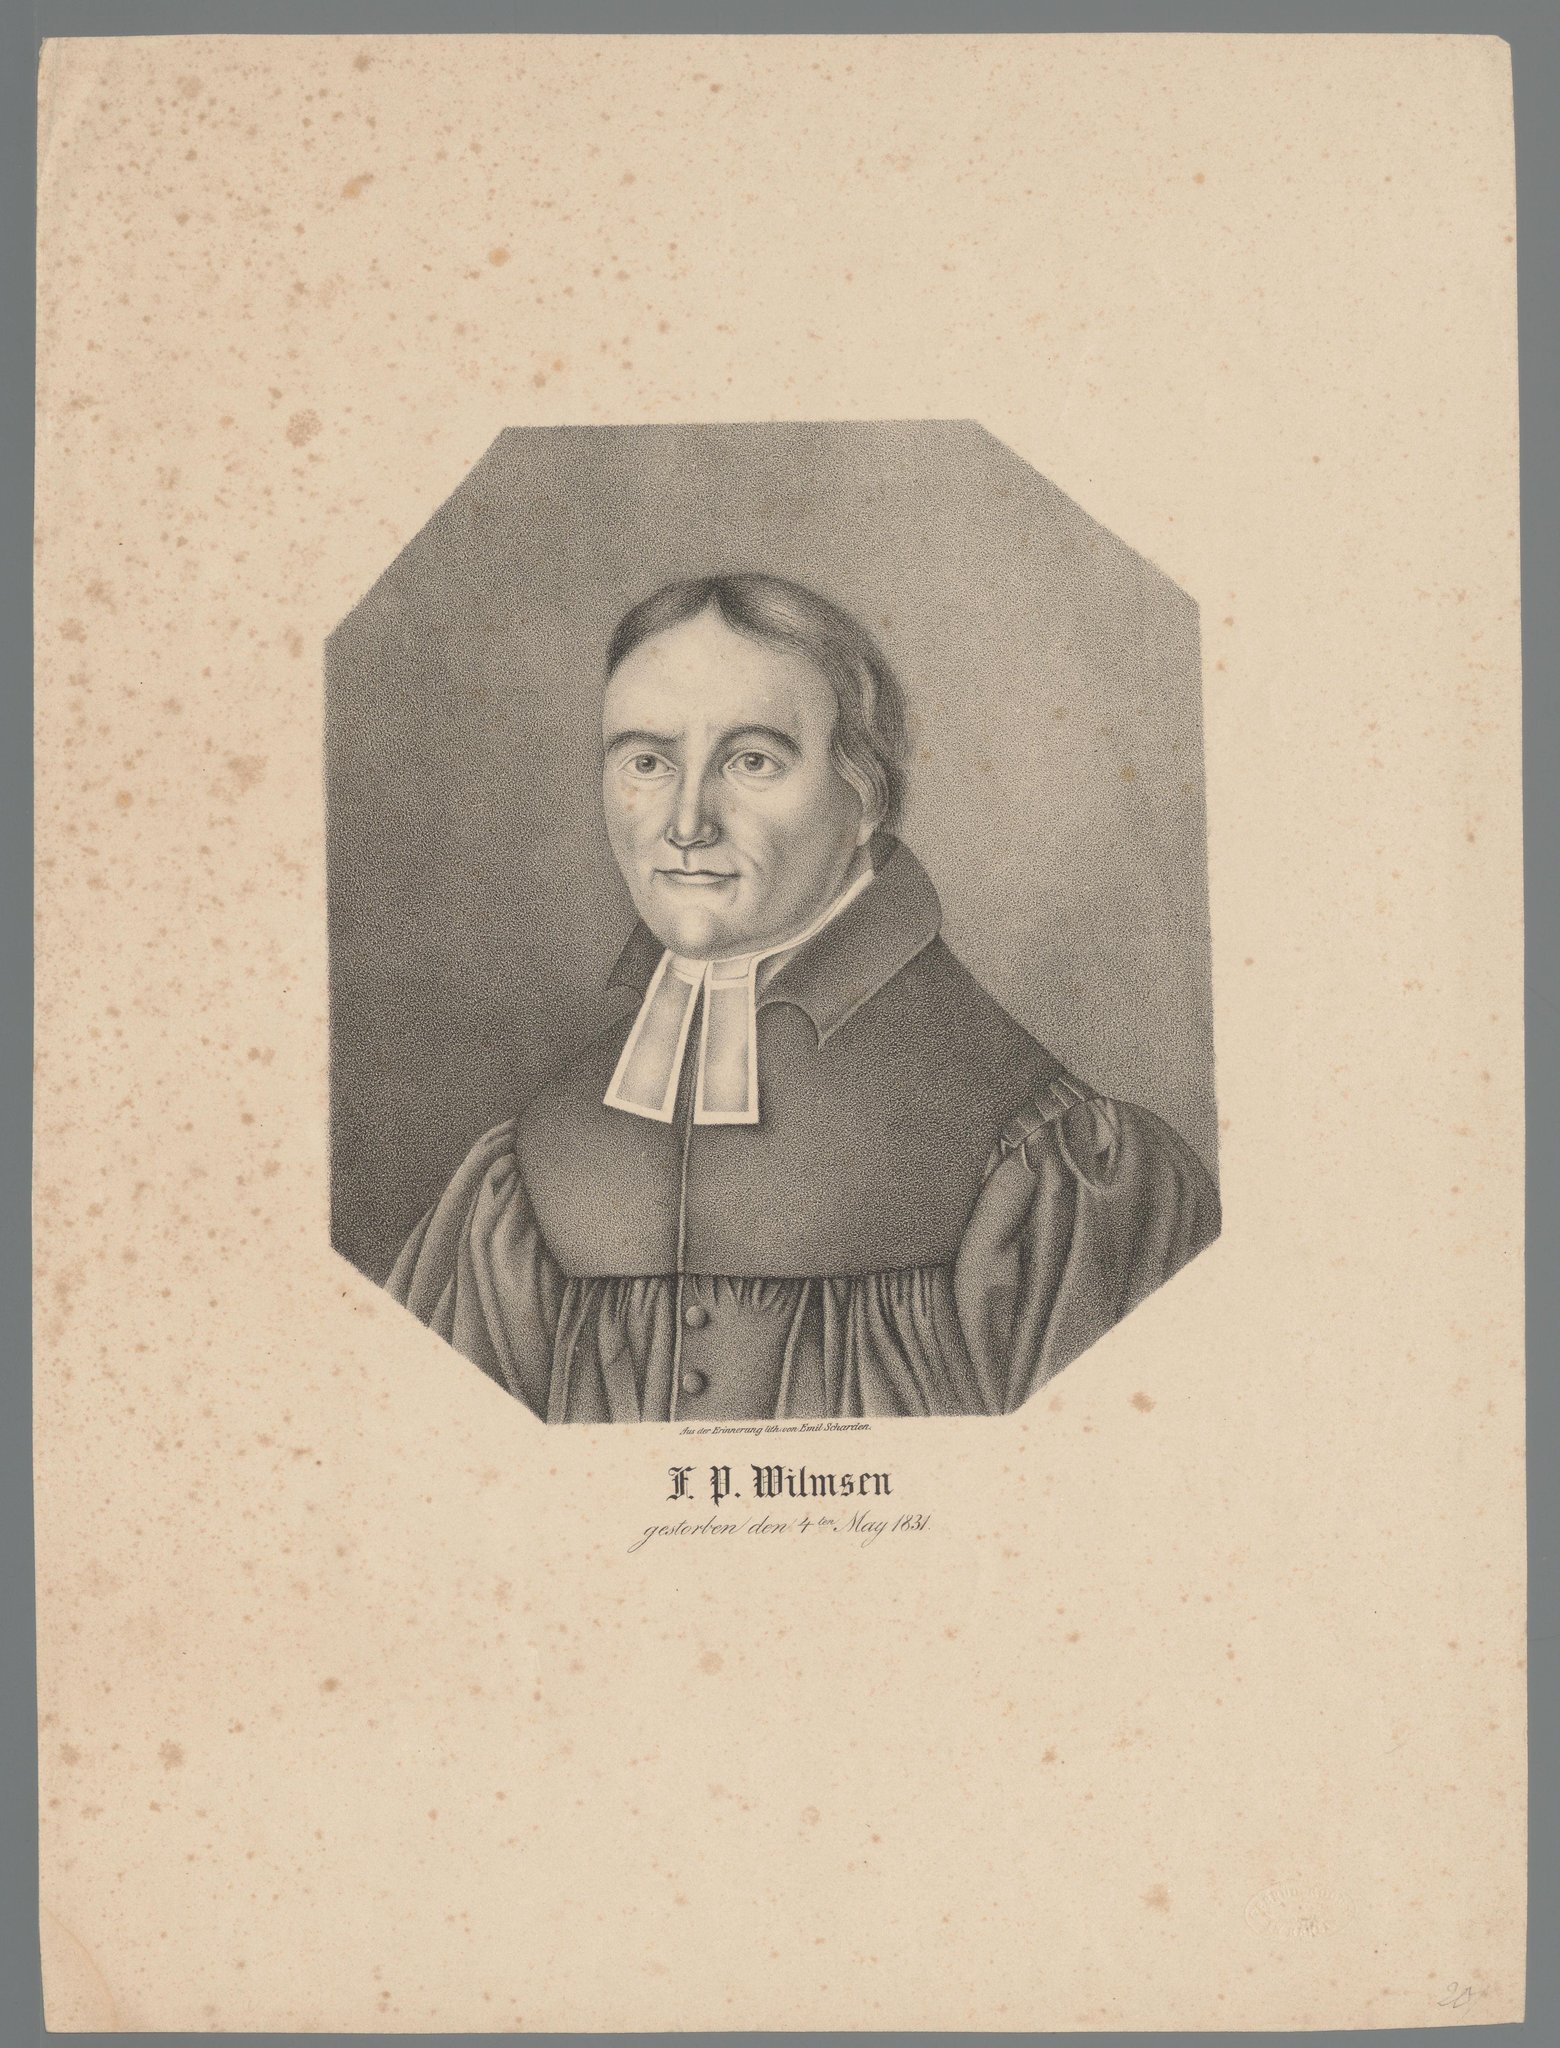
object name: print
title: F.P. Wilmsen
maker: emile scharden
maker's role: print maker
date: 1831-1850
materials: paper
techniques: lithograph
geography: berlin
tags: adult man, historical persons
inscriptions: collector's mark: Lugt 2228, check stamp: Lugt 2141c